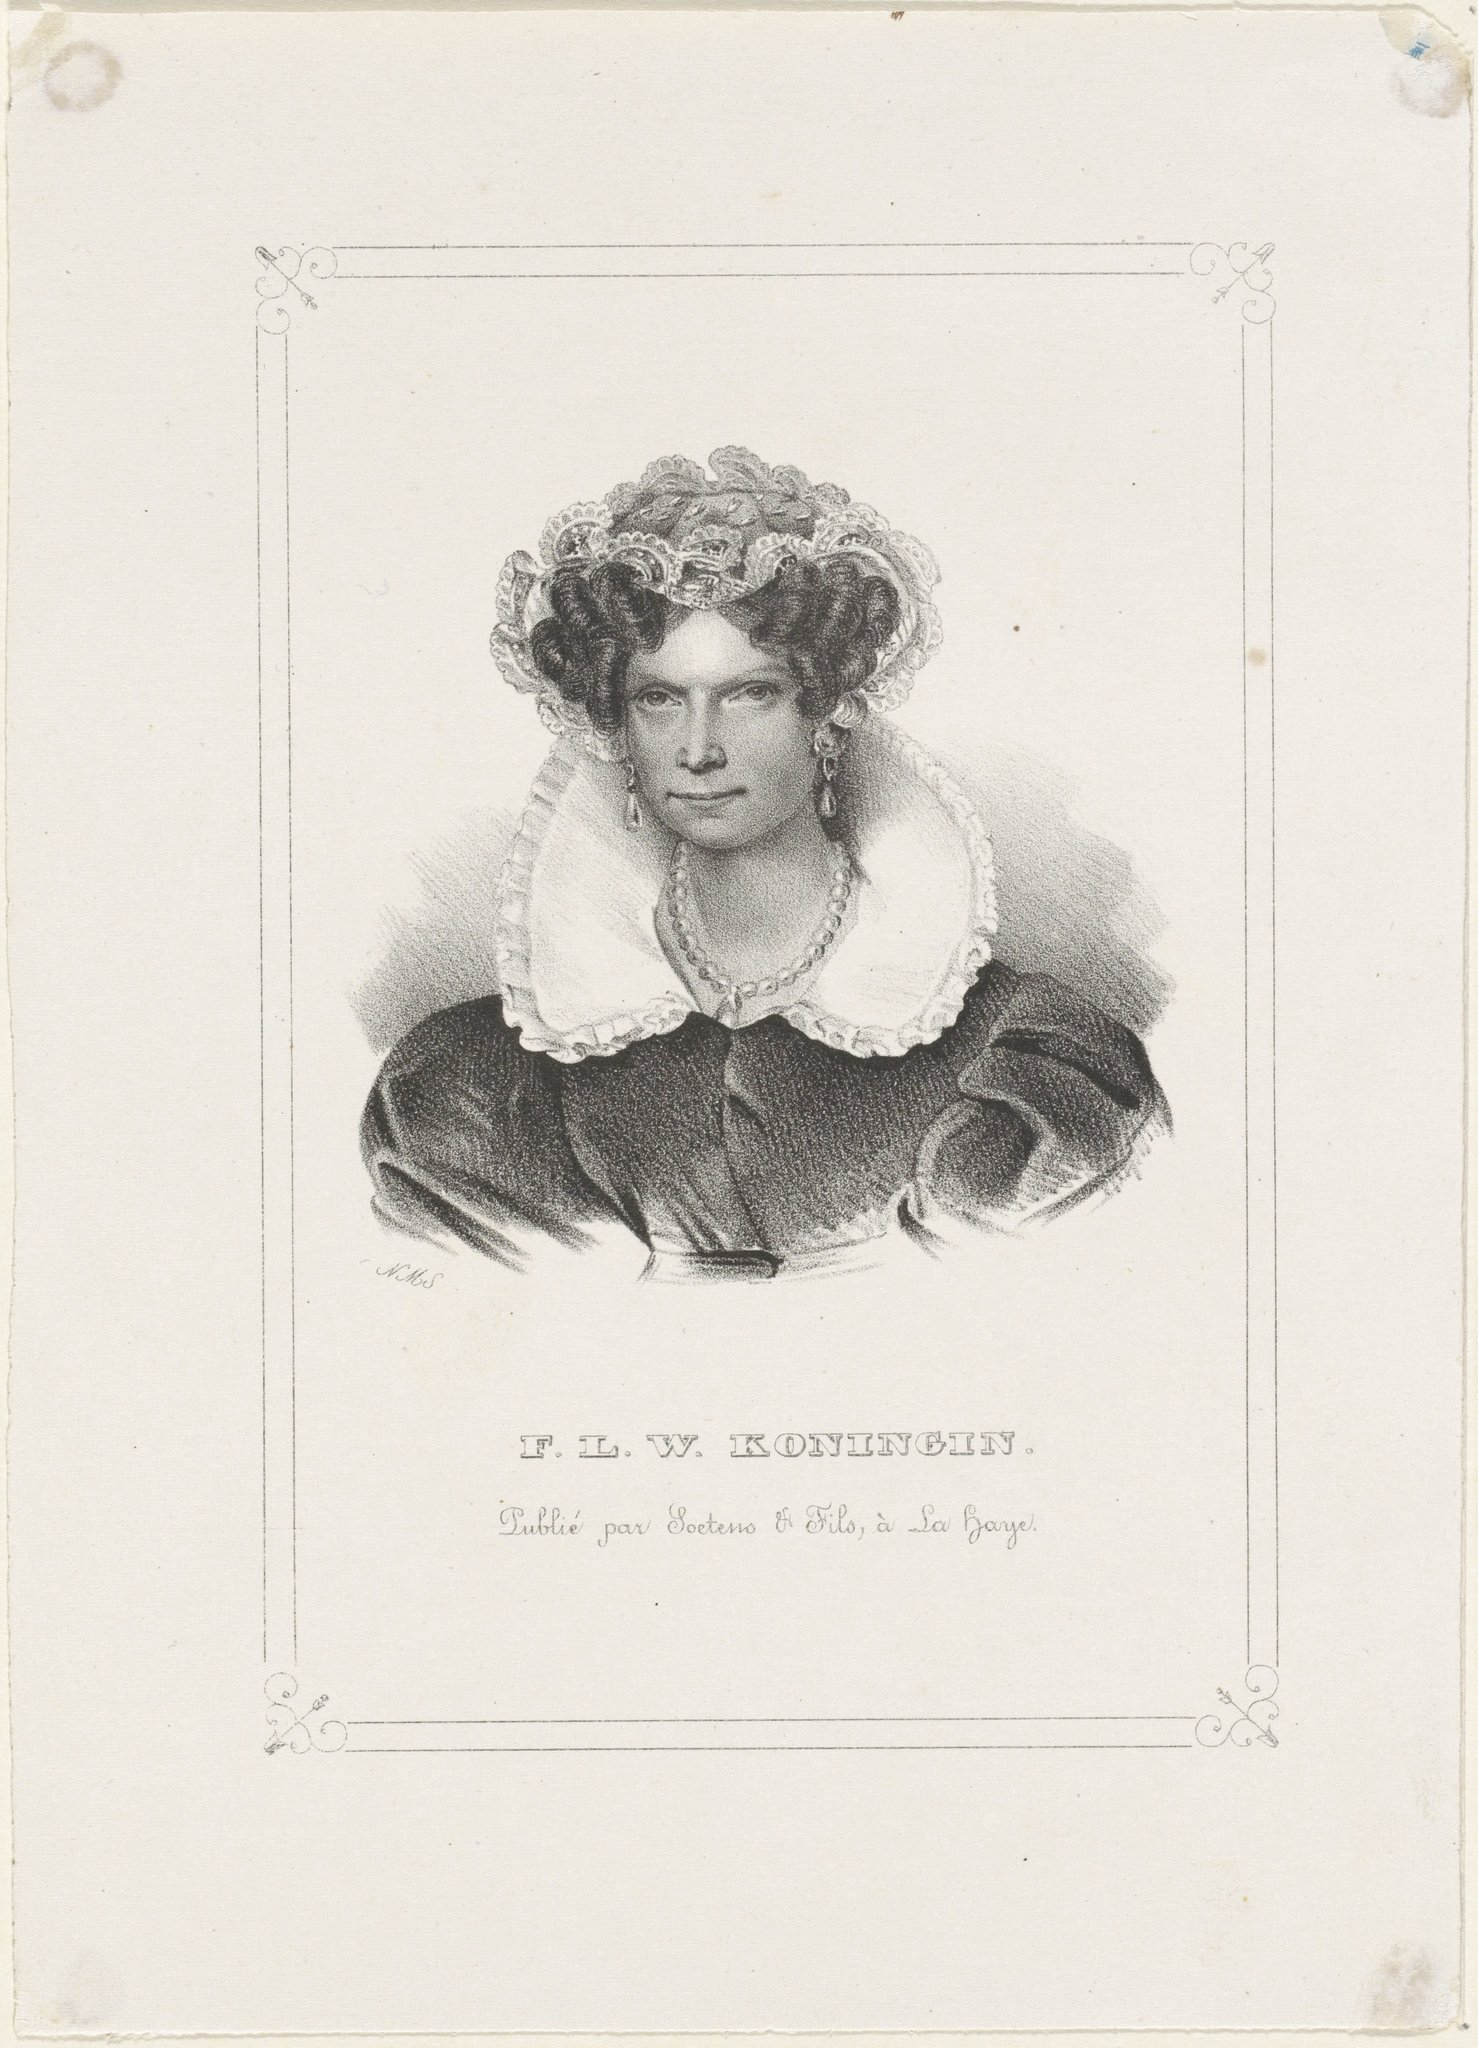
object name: print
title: Portret van Wilhelmina van Pruisen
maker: nicolaas martinus schild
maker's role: draughtsman, print maker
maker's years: 1822-1840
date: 1837-1840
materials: paper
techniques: lithograph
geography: netherlands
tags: the hague, wilhelmina frederica louisa (koningin der nederlanden)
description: Portret van Wilhelmina in een geornamenteerde rechthoek. In de ondermarge haar naam en titel.